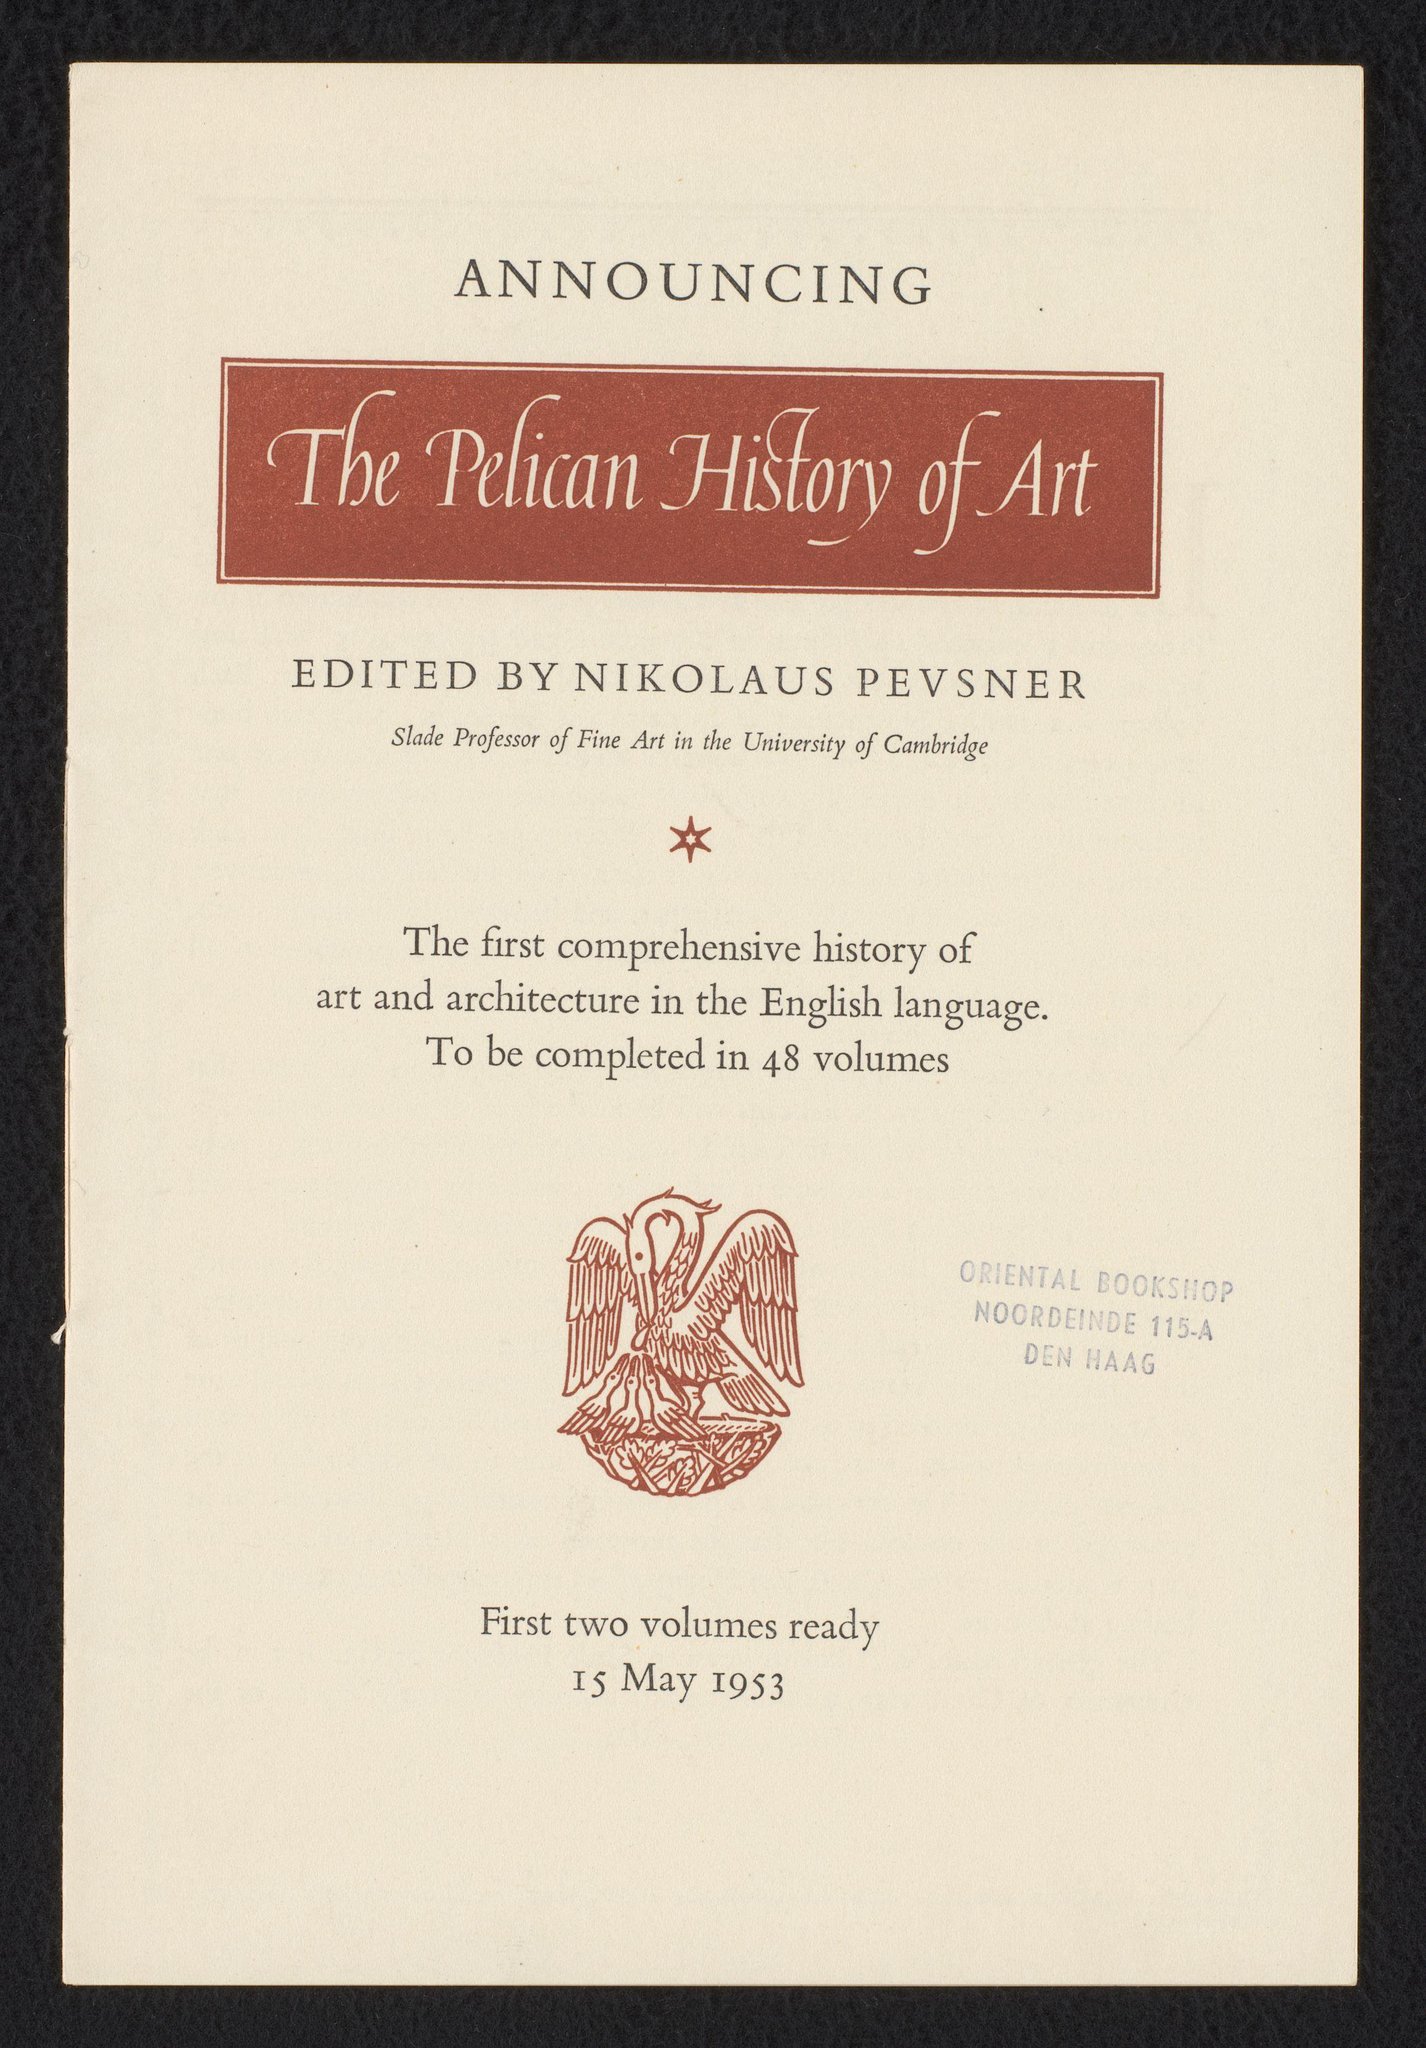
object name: photomechanical print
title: Prospectus voor de reeks 'The Pelican History of Art'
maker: Anonymous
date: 1953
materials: paper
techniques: bookbinding, letterpress printing, printing block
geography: england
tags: history of art, water-birds: pelican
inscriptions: stamp: ‘Oriental Bookshop, Noordeinde 115-A, Den Haag’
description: Prospectus van twaalf pagina's en los ingelegd bestelformulier. Naast een algemene beschrijving van de voorgestelde reeks en afzonderlijke delen, enkele voorbeeldillustraties en voorbeeldpagina's van de tekst.